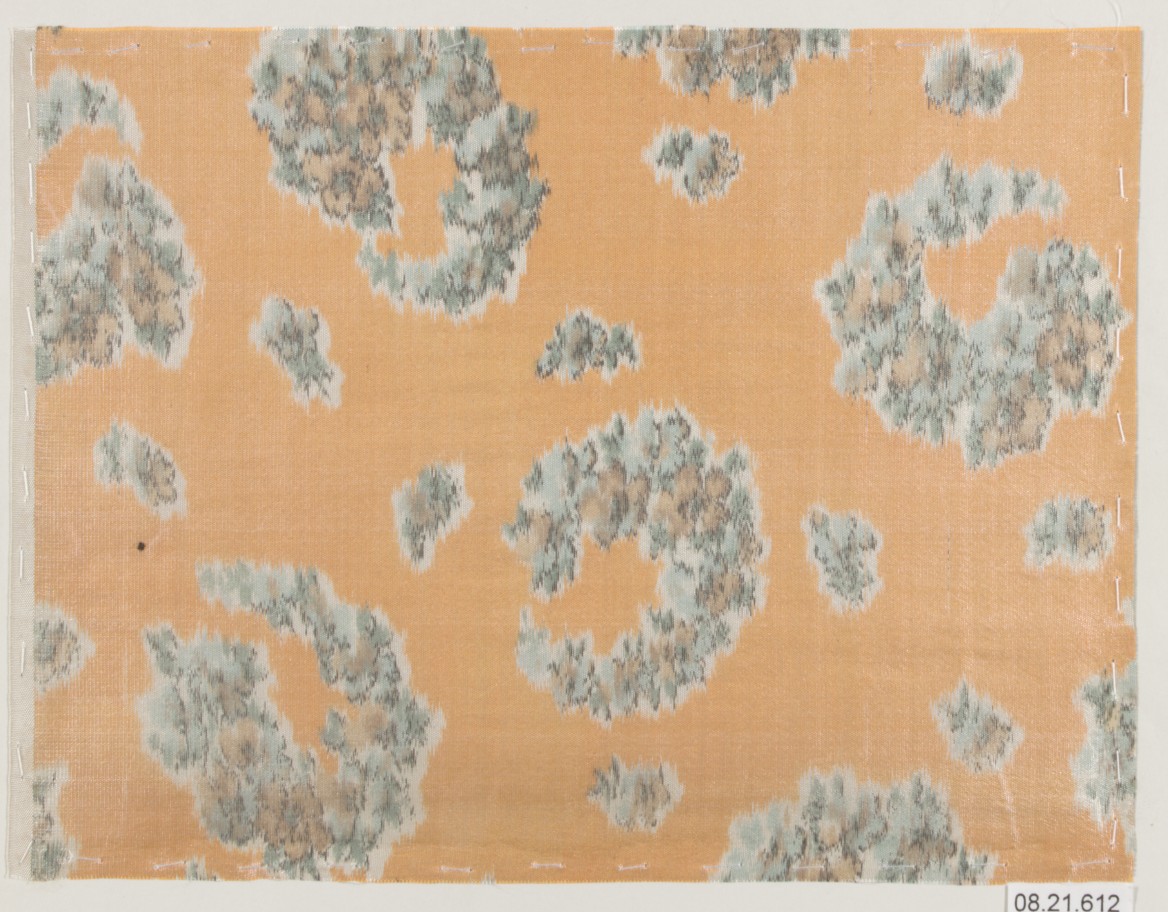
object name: textile sample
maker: Anonymous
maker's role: designer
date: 1900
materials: silk